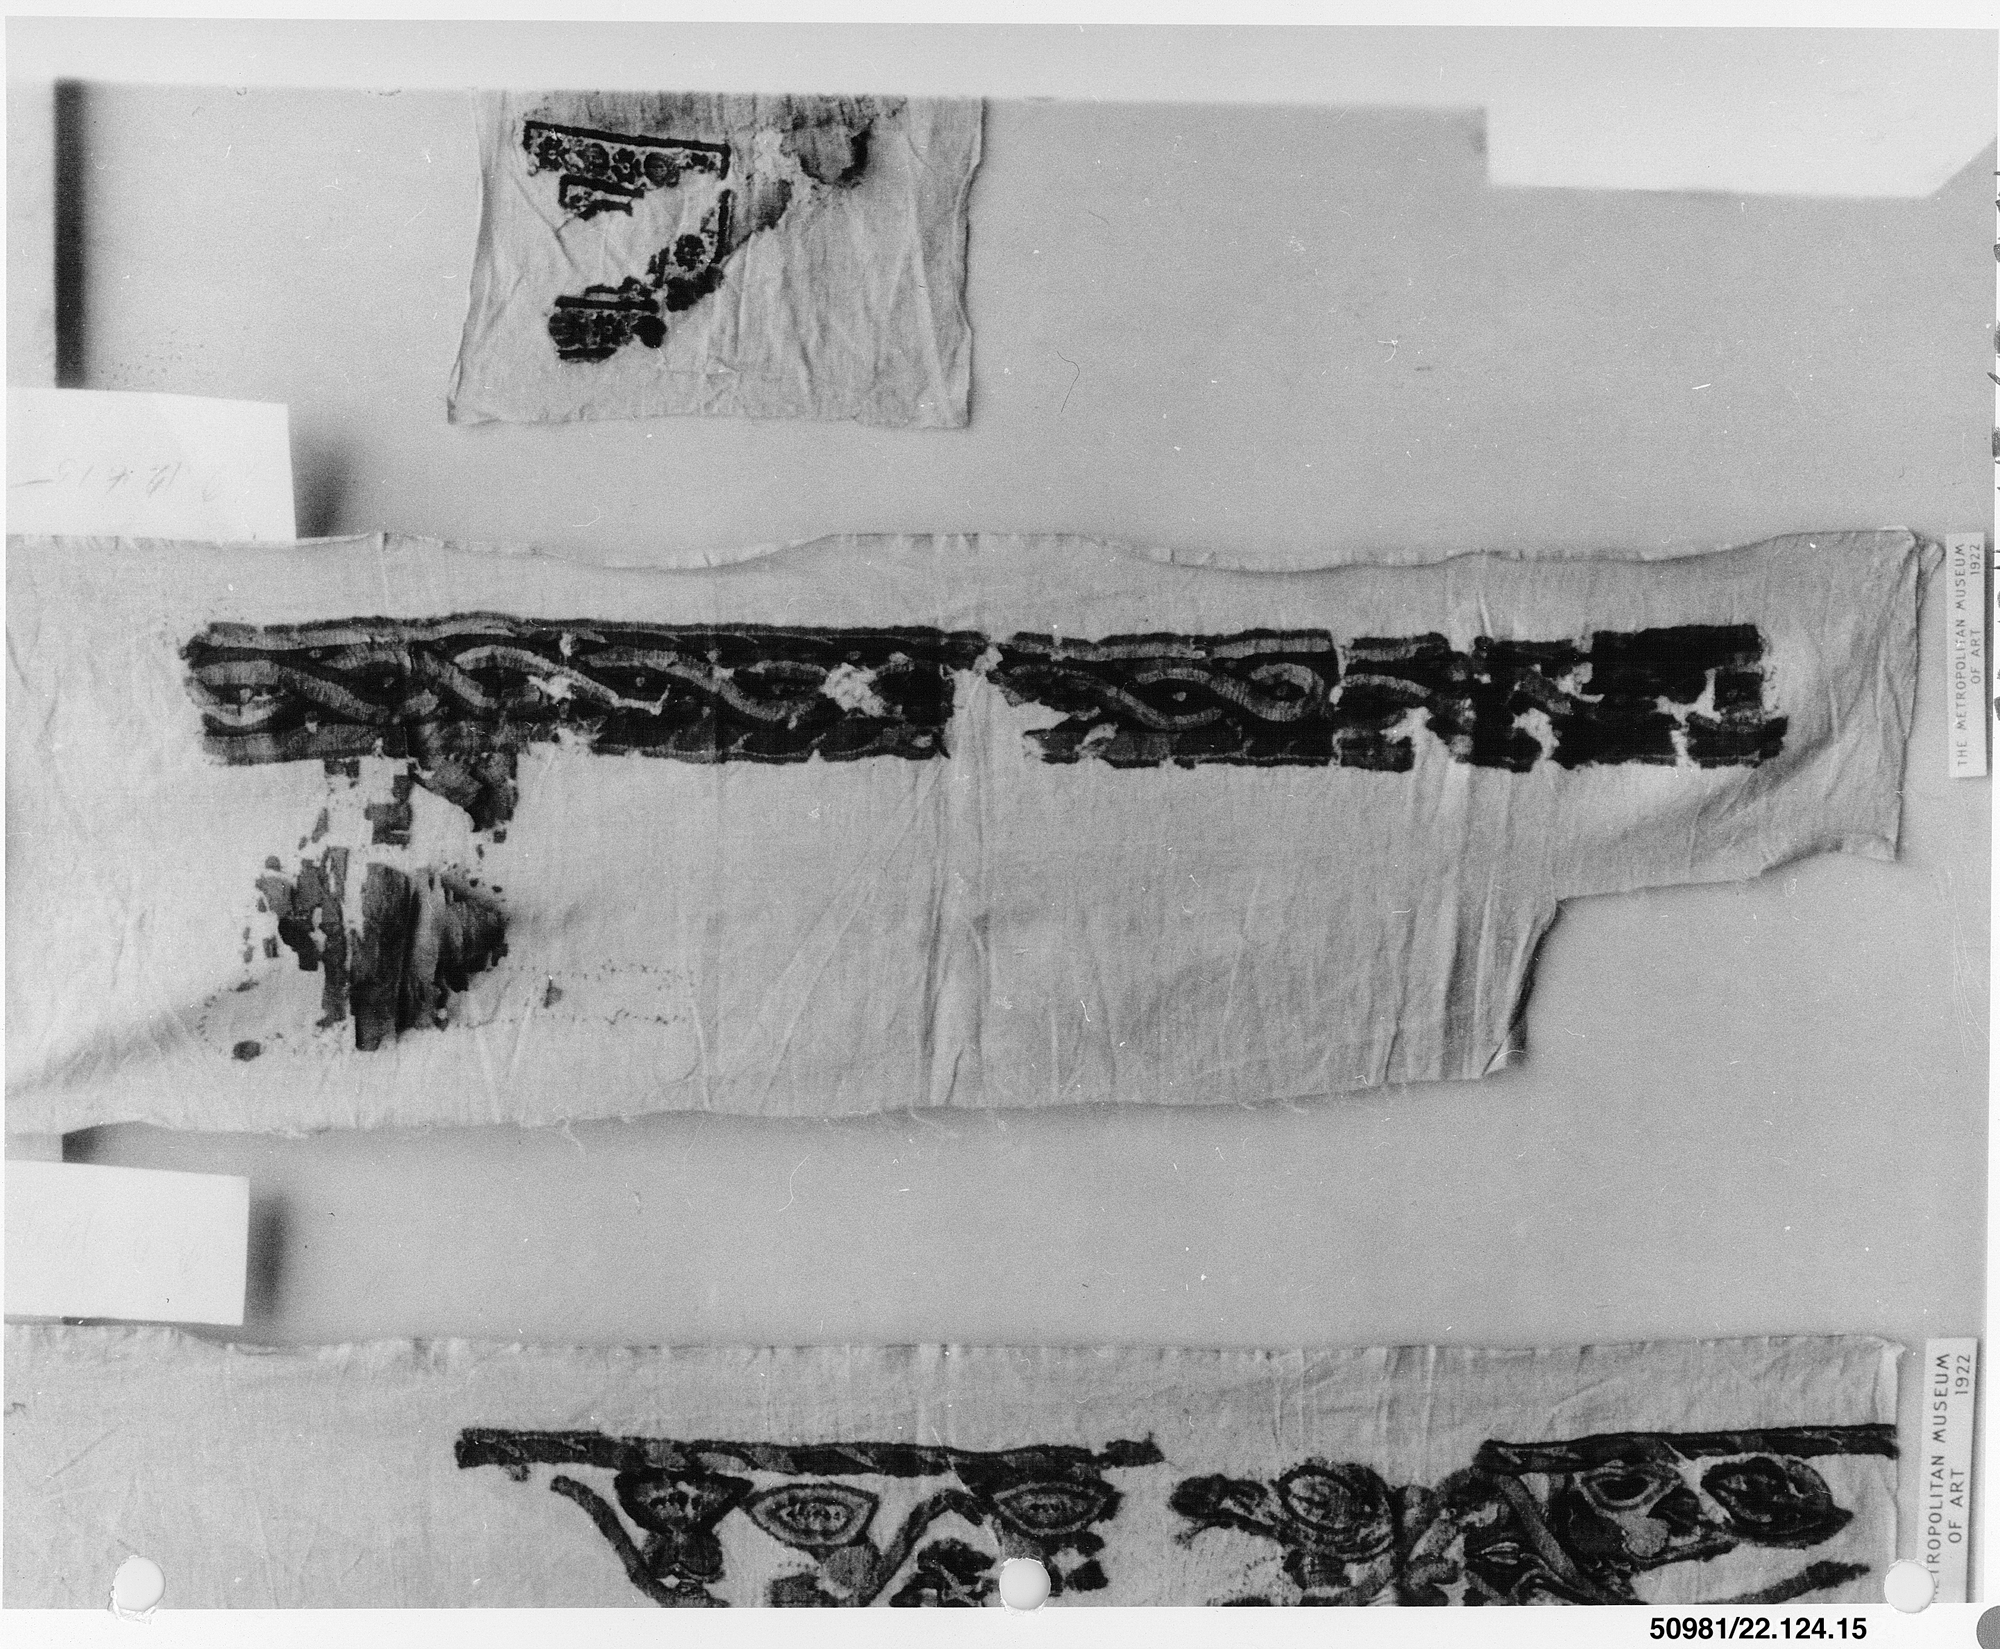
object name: fragment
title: Textile Fragment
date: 301-600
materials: linen, wool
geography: egypt